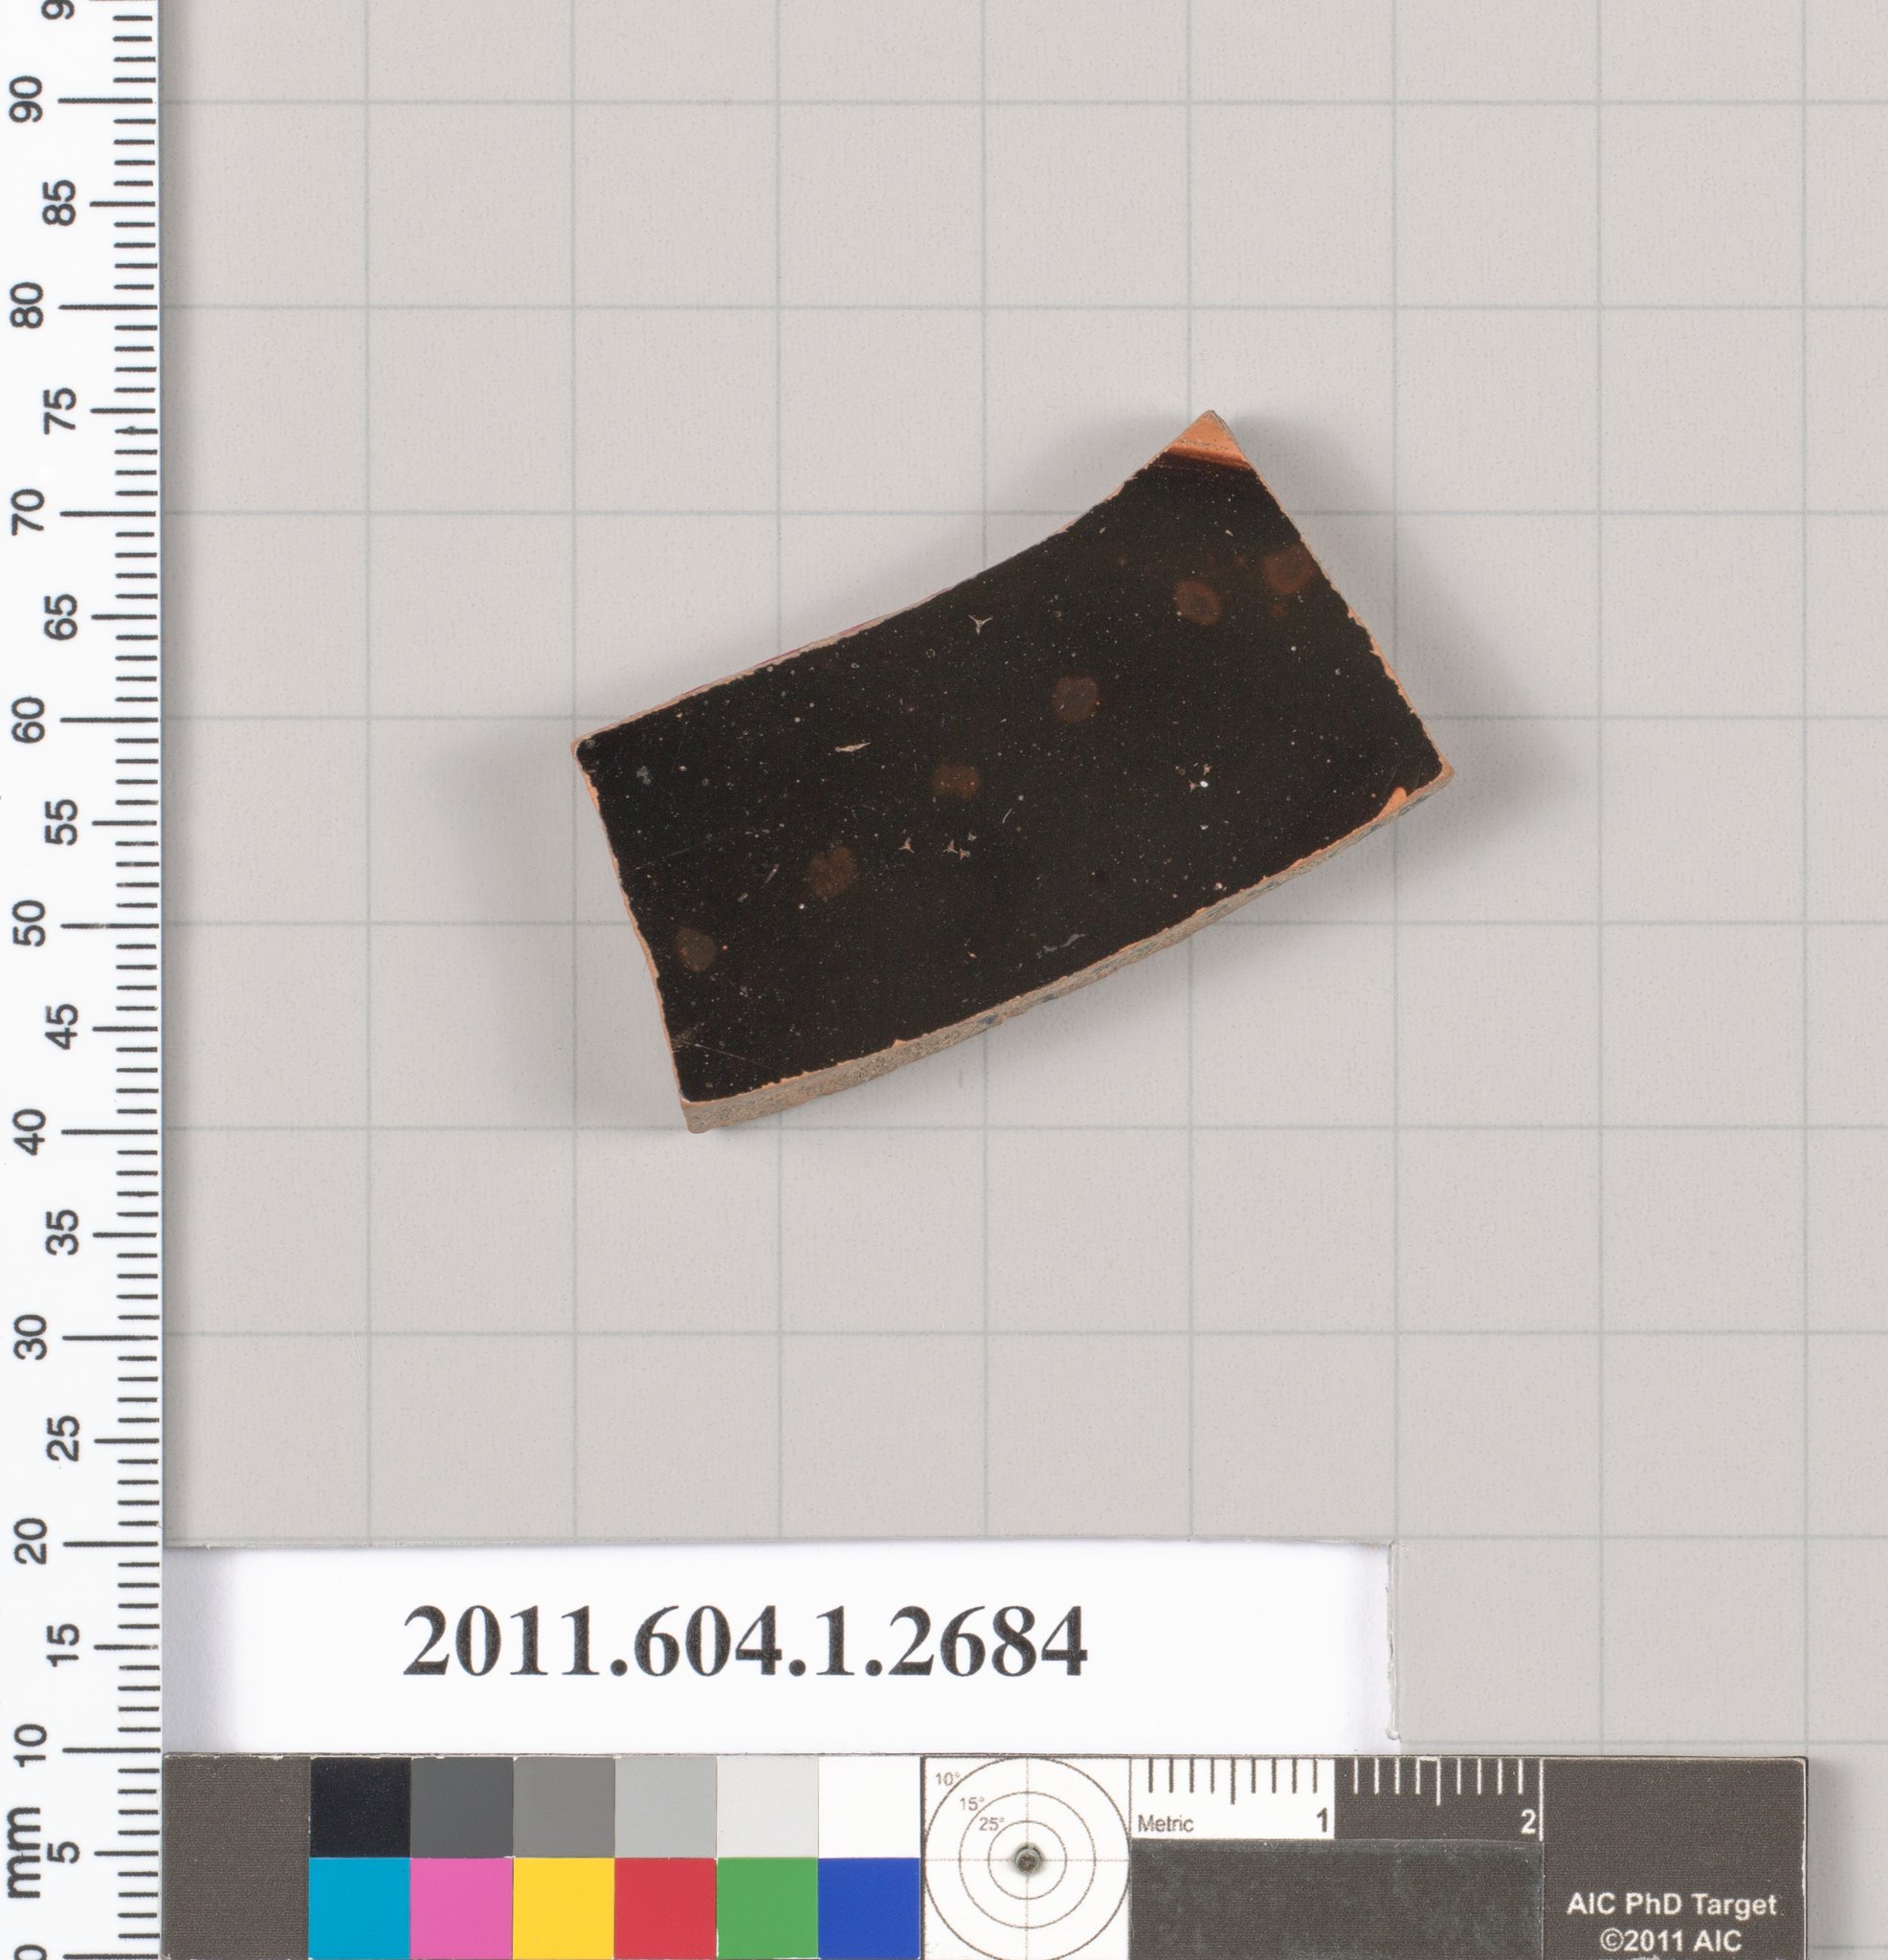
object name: kylix fragment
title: Terracotta fragment of a kylix (drinking cup)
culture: greek, attic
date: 500-476 BCE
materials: terracotta